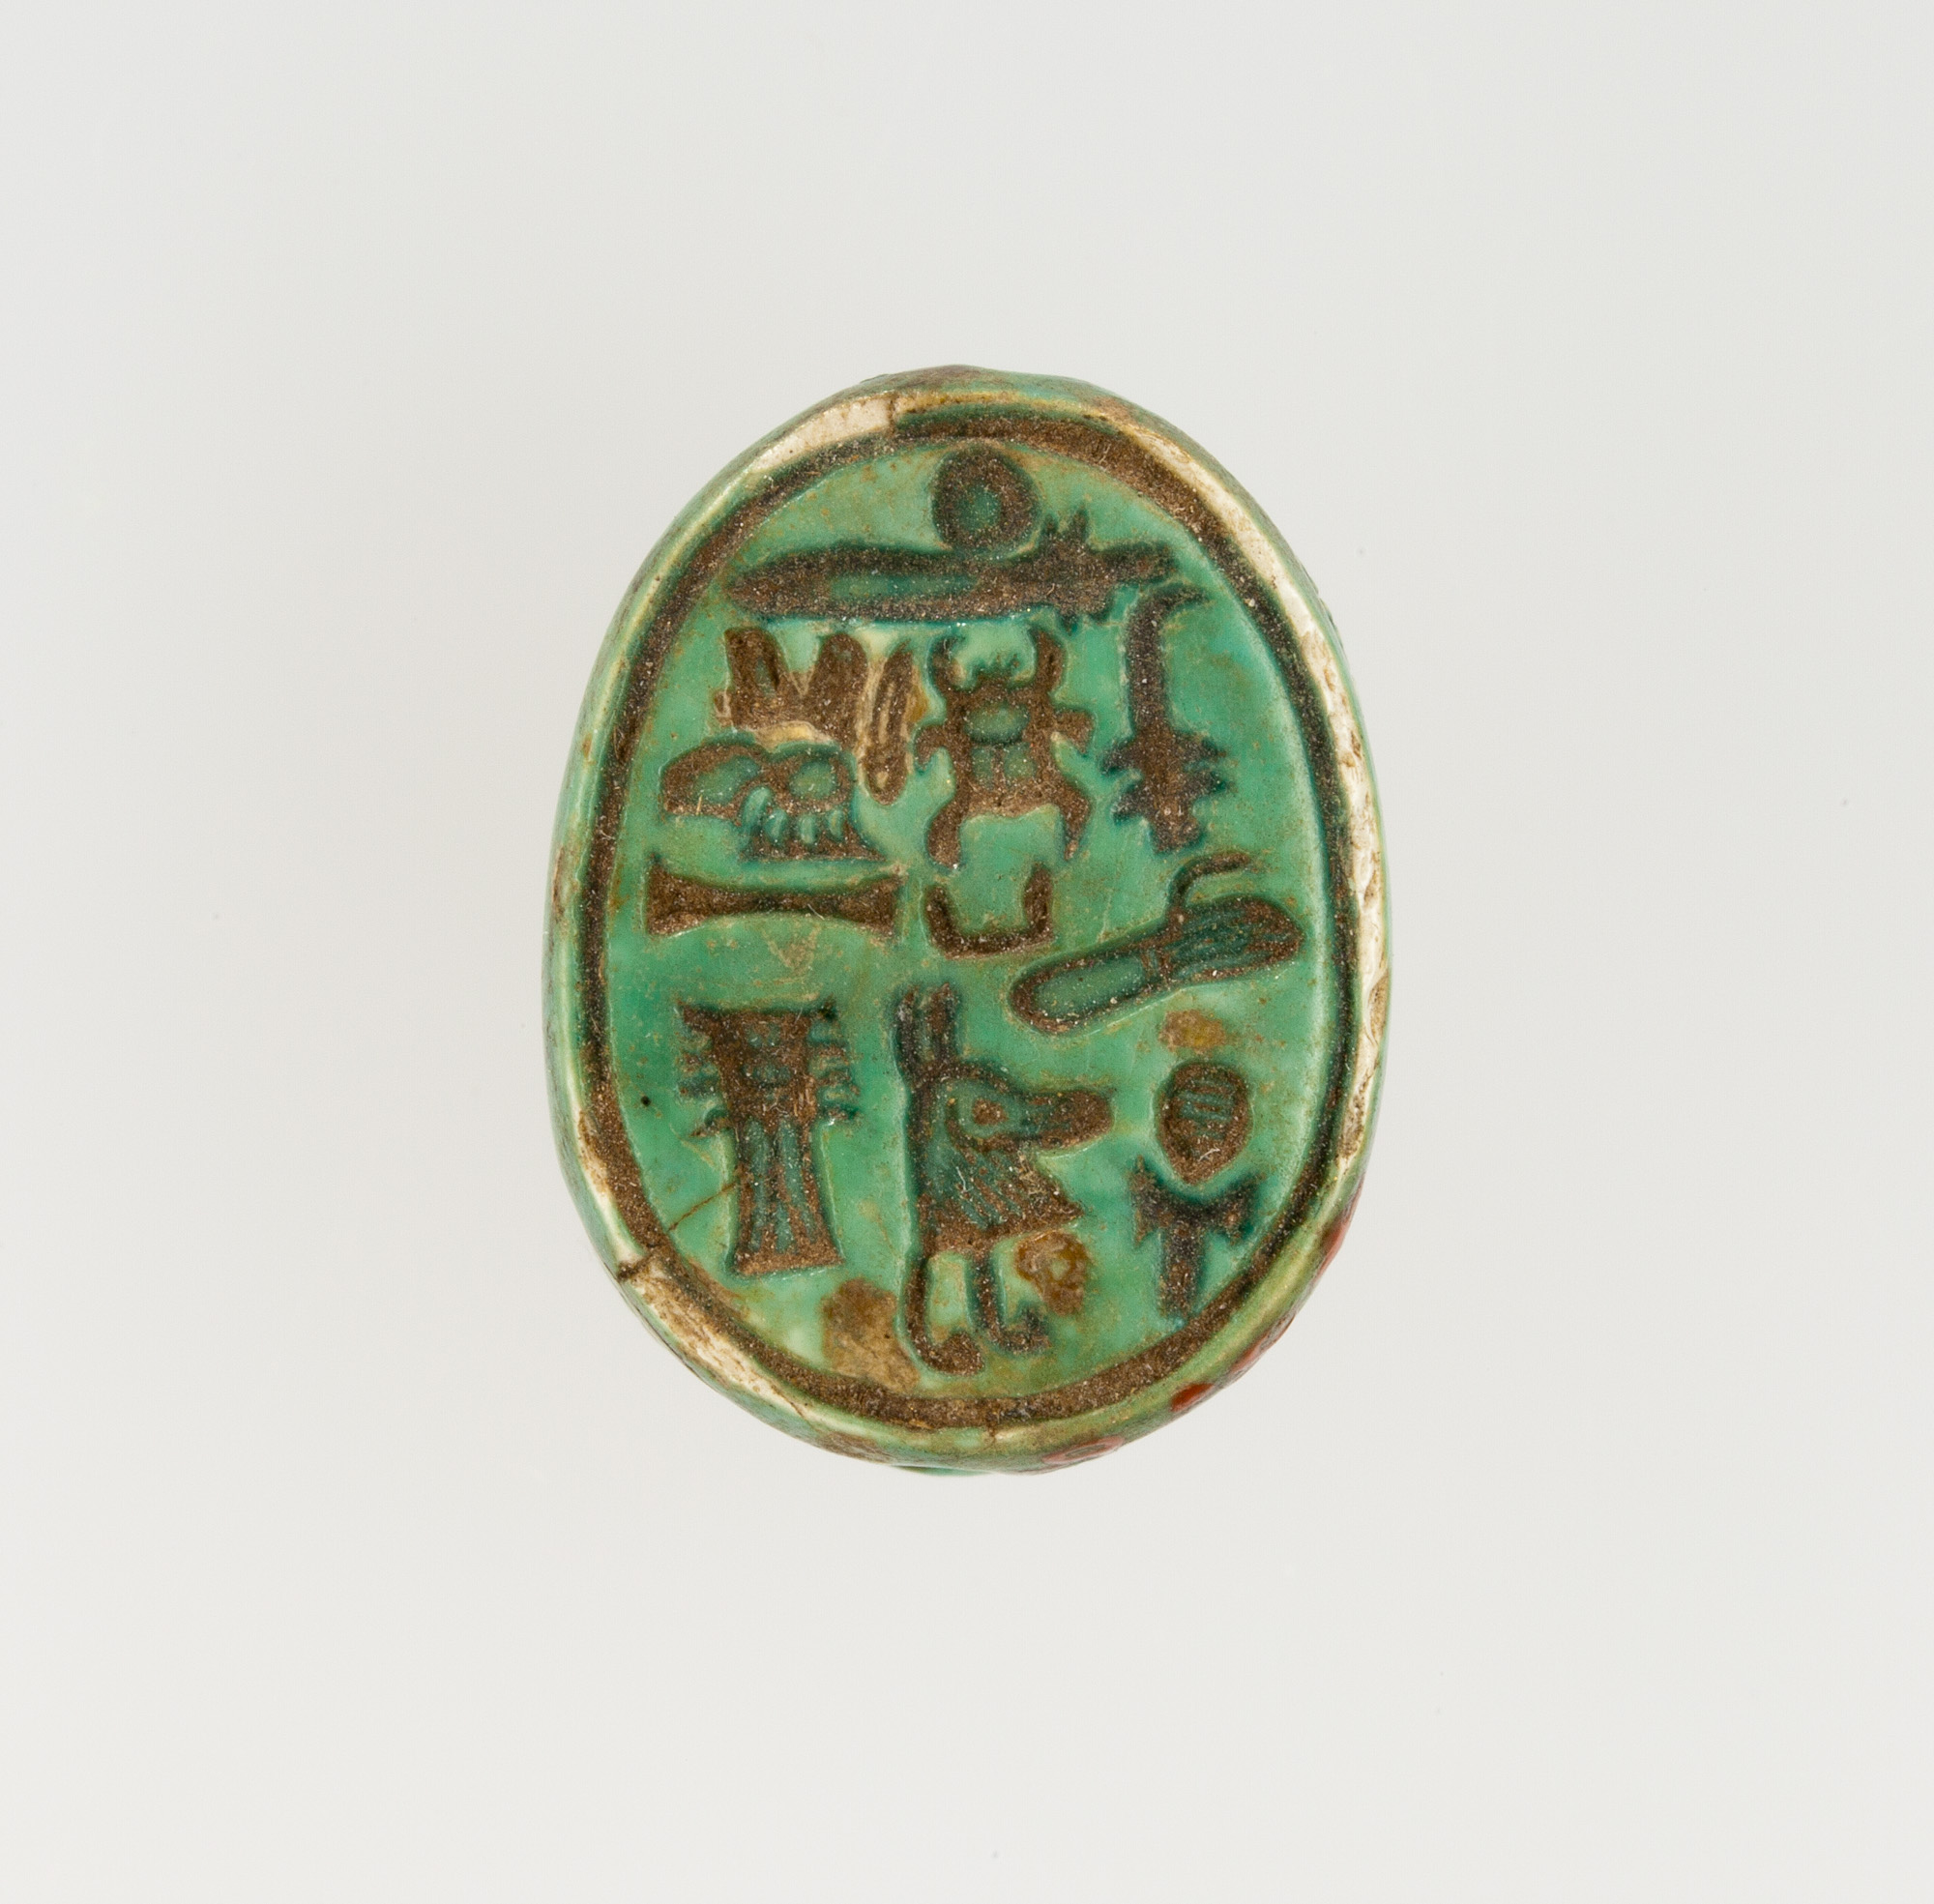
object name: scarab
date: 1550-1295 BCE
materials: stone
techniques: glazing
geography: egypt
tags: hieroglyphs,scarabs